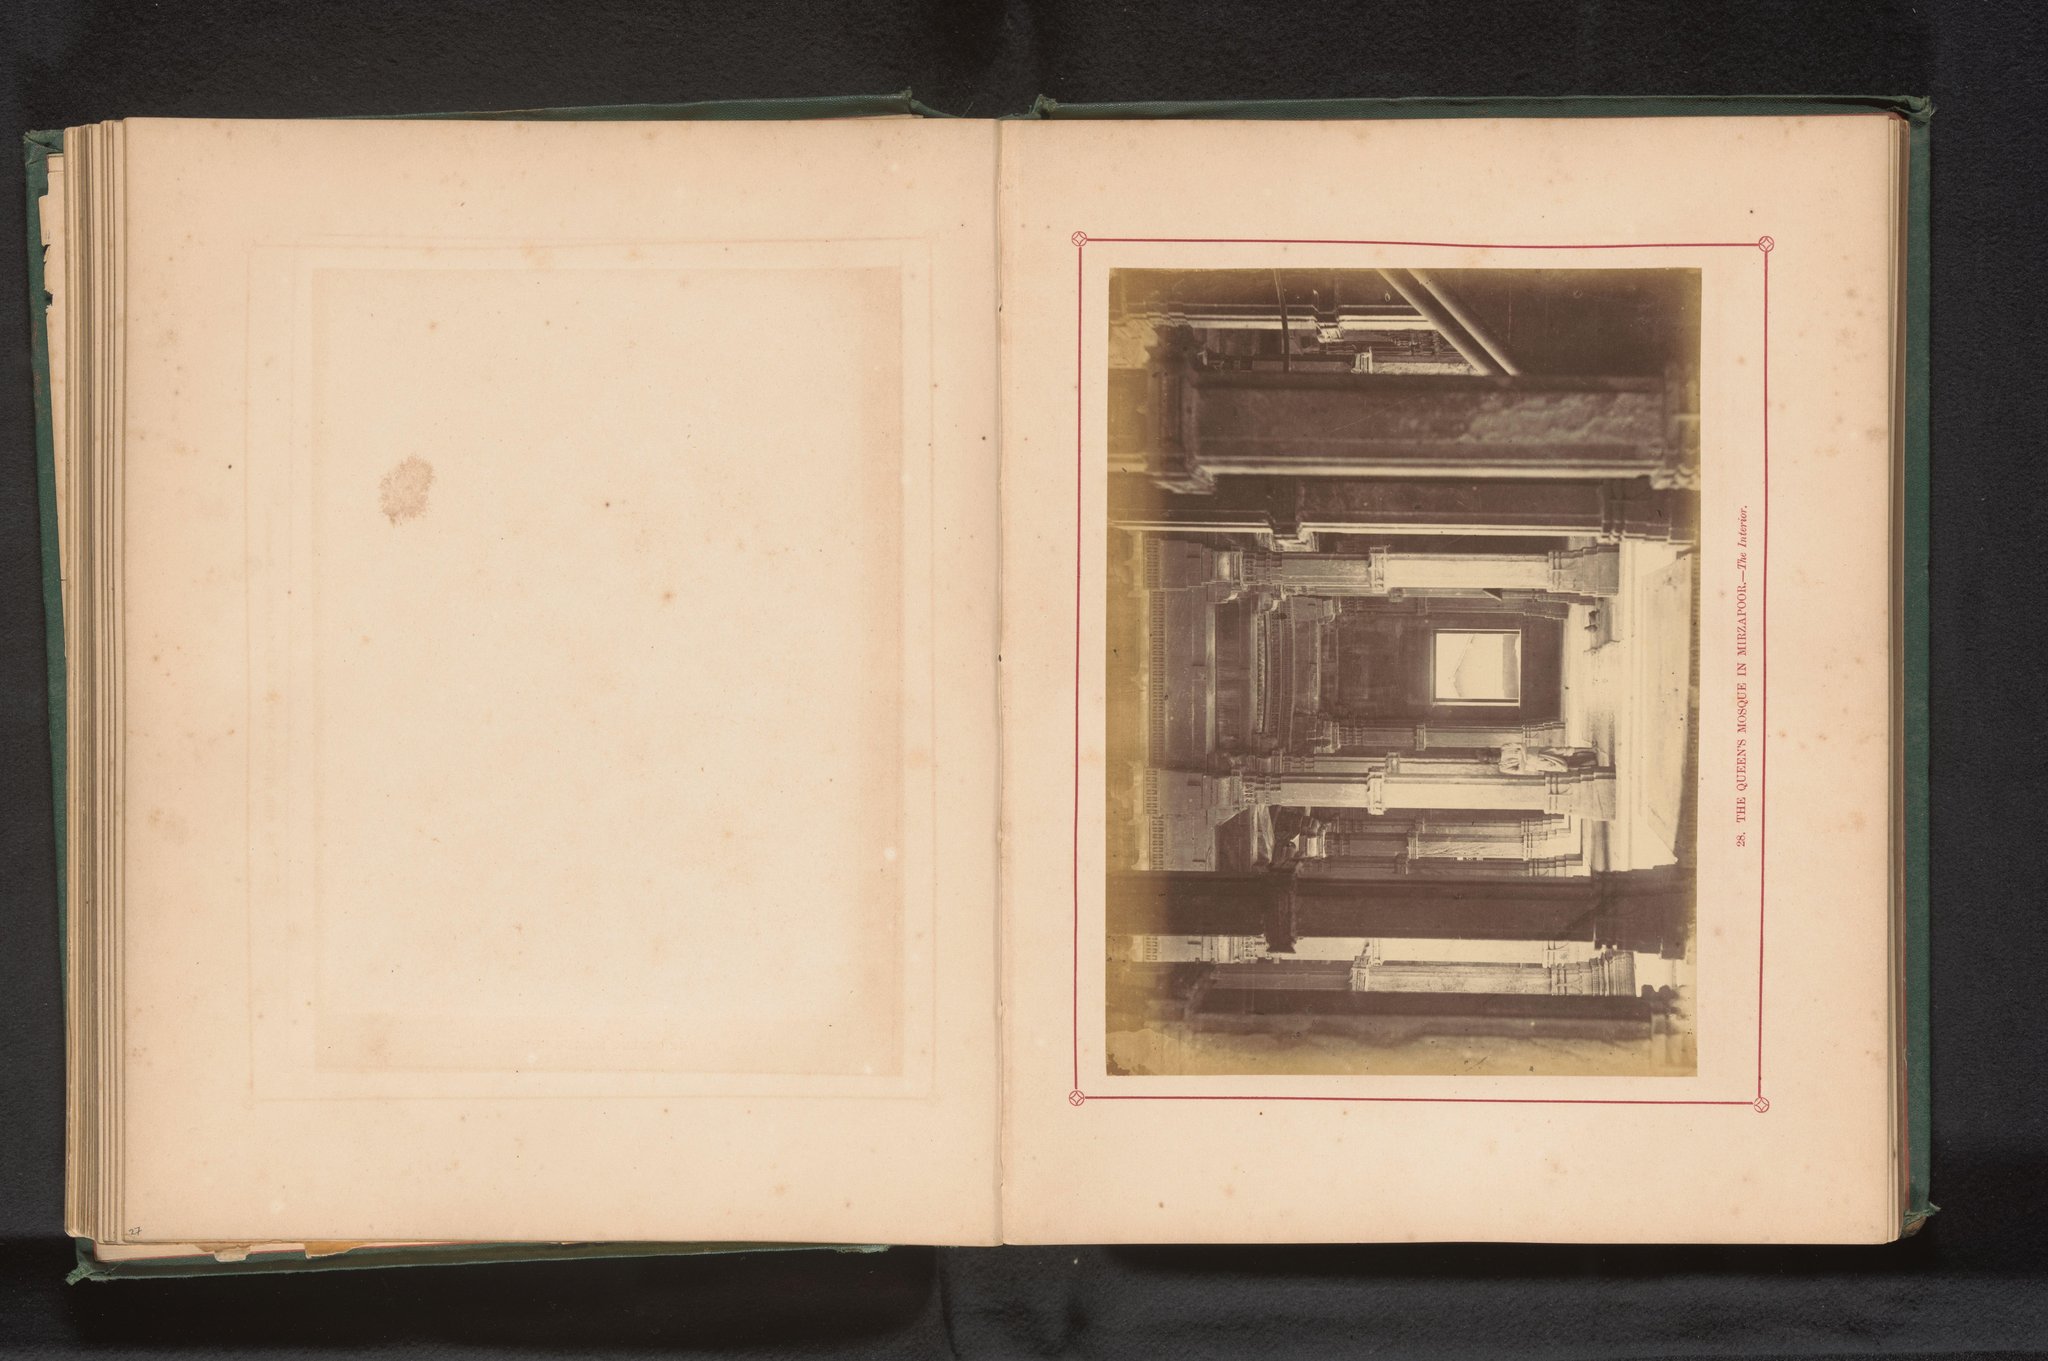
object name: page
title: The Queen's Mosque in Mirzapoor.- The interior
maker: thomas biggs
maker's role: fotograaf, kapitein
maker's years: 1822-1905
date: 1856-1866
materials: photographic support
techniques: albumen print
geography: ahmedabad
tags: column, pillar ~ architecture, temple, shrine ~ islam, mohammedanism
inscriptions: number: ‘28.’